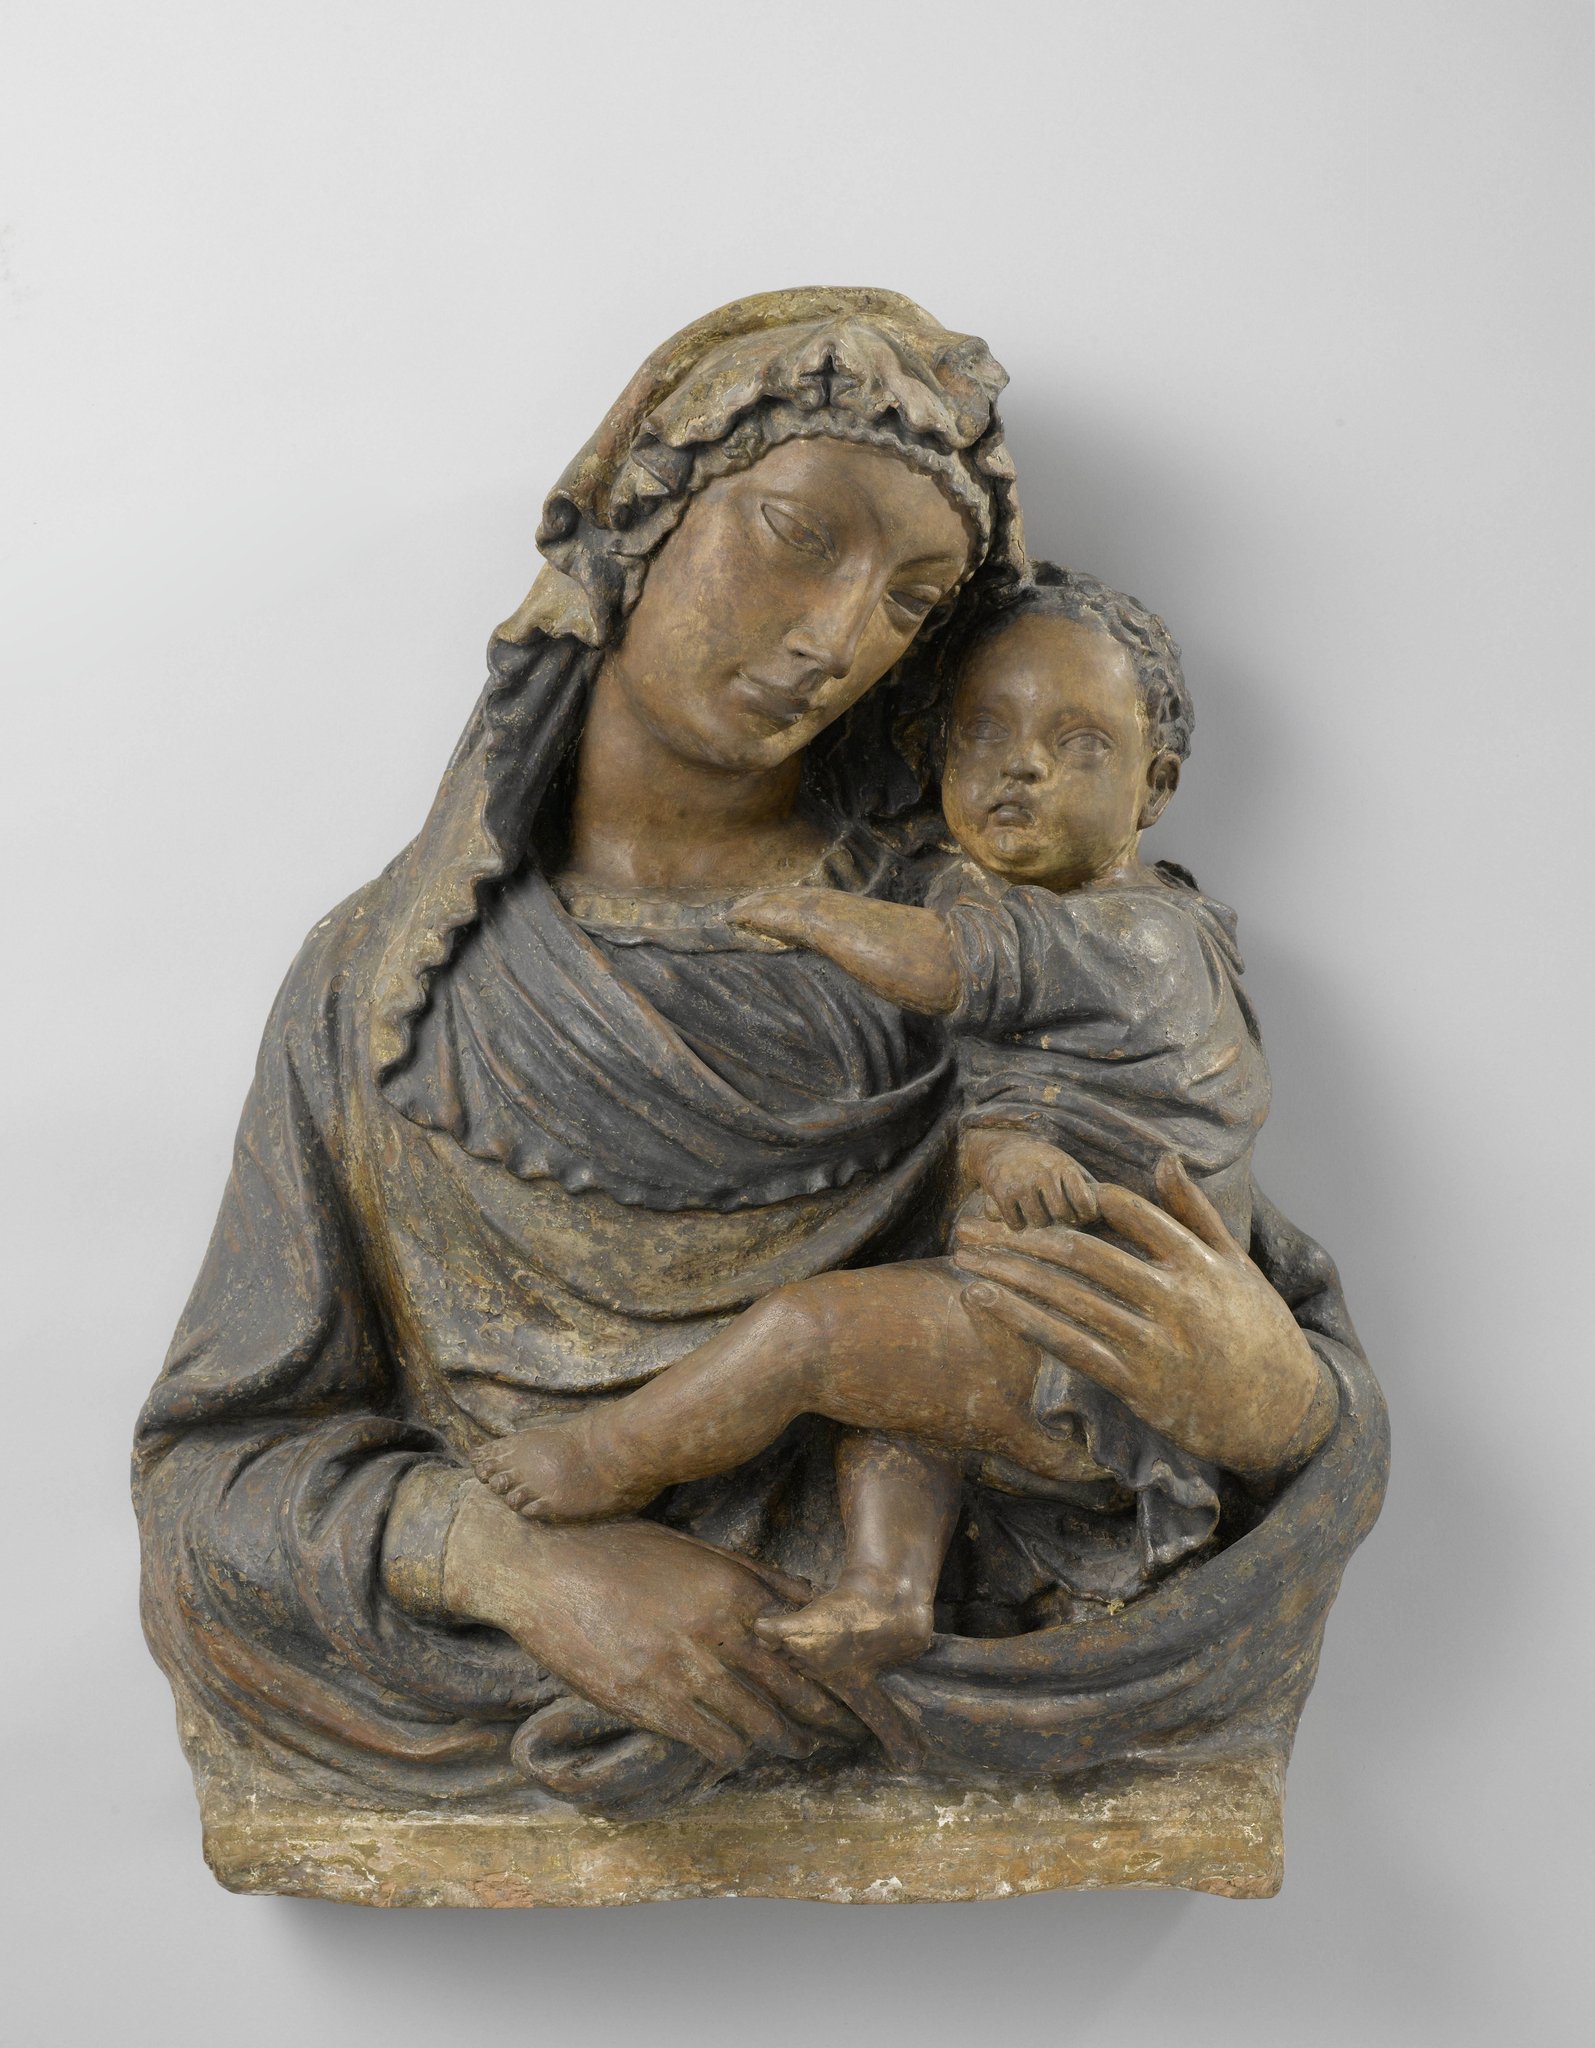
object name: sculpture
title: Maria met kind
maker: Anonymous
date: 1400-1500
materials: terracotta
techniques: modeling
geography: siena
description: Virgin and Child. Terracotta with polychromy. Florence, c. 1440.